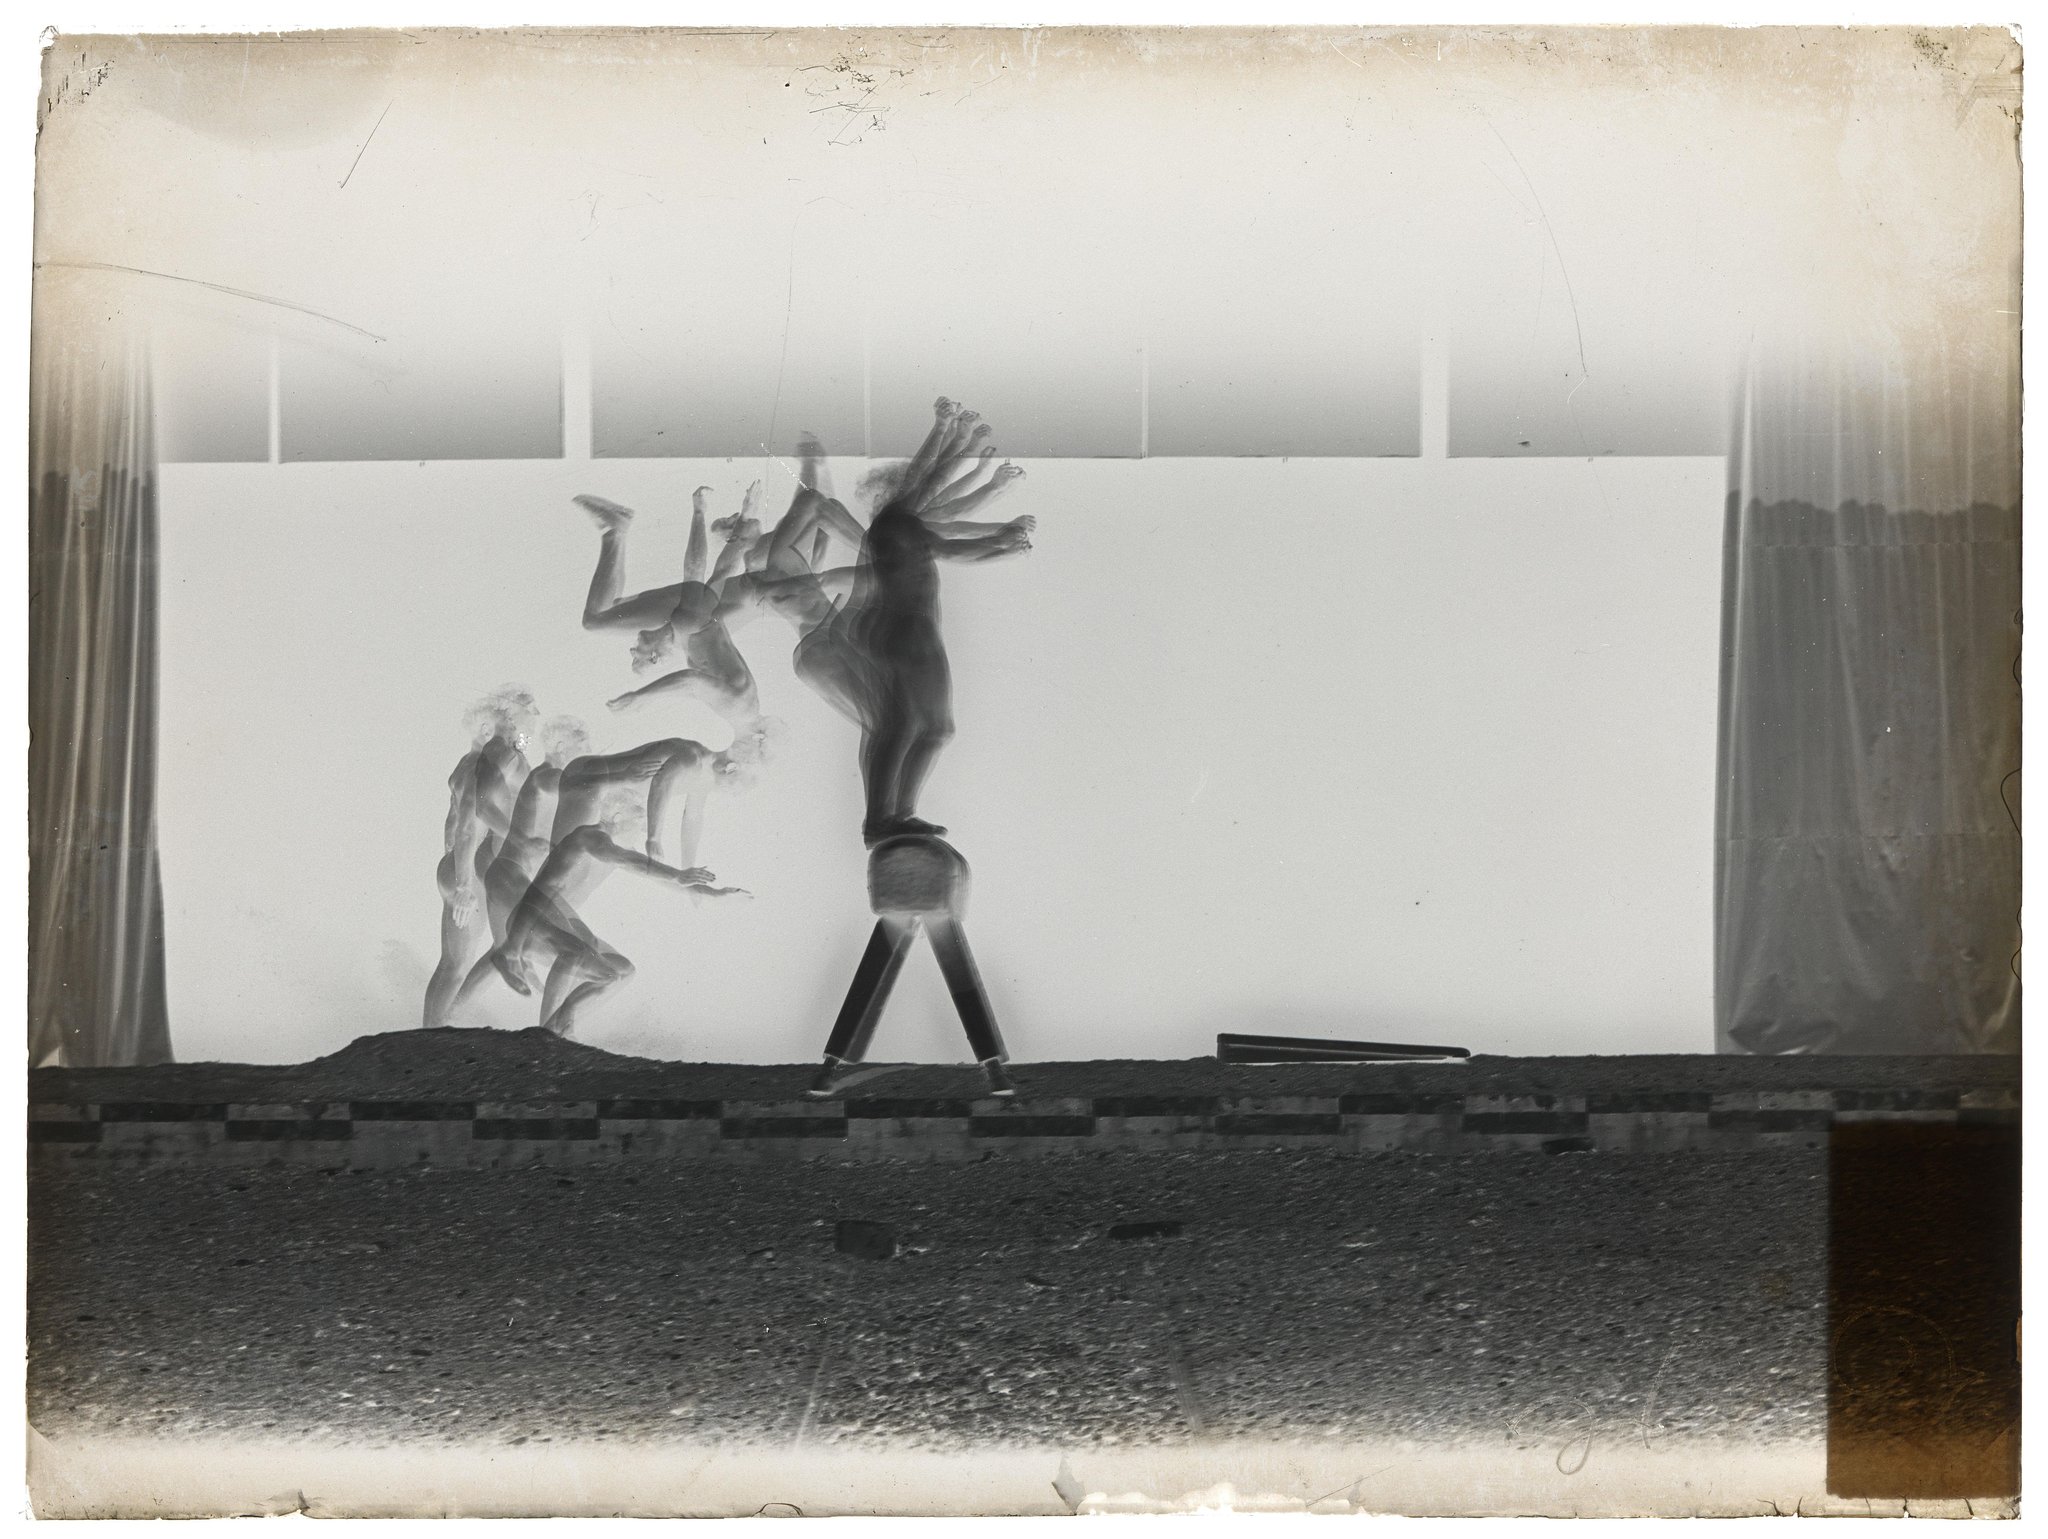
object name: glasnegatief, glasplaatnegatief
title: Man Making a Headstand on a Pommel Horse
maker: étienne-jules marey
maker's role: fotograaf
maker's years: 1830-1904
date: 1882-1890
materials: glass, paper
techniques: gelatin glass negative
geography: france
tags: vaulting horse (gymnastics), movements of the human body, adult man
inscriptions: inscription: ‘Ki 13’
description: Bij de negatieven zijn ook de duplicaatnegatieven en moderne afdrukken die voor de boekpublicatie vervaardigd zijn.